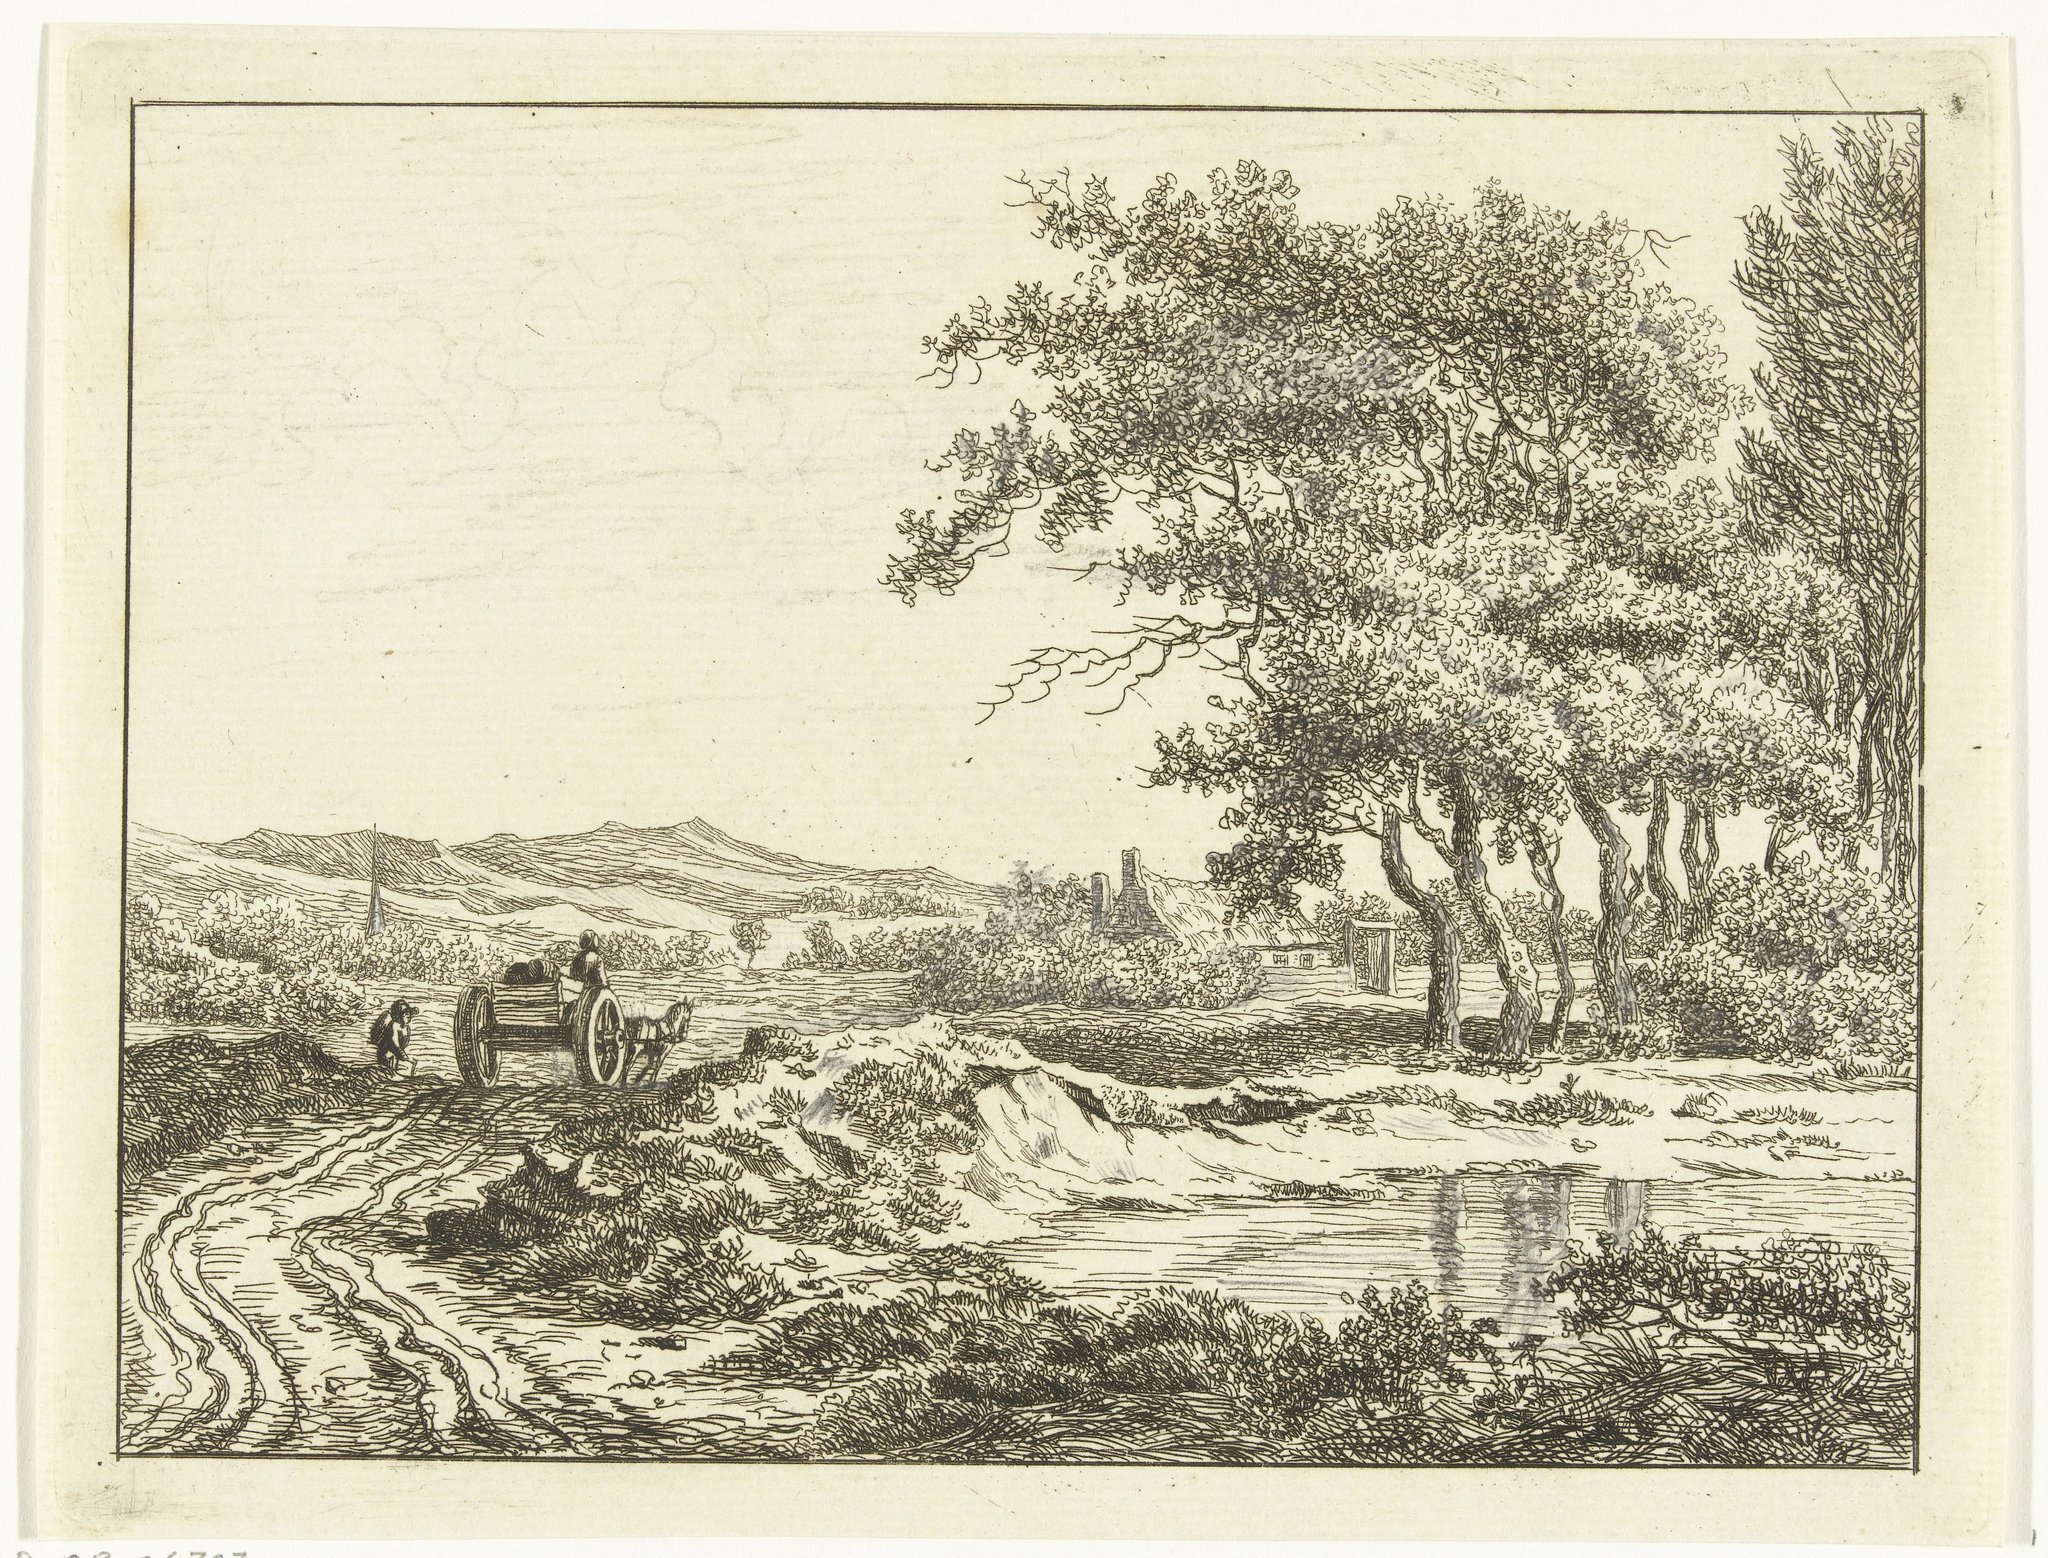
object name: print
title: Kar op een landweg bij de duinen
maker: anthonie van den bos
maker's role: draughtsman, print maker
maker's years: 1763-1838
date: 1778-1838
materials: paper, pencil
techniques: etching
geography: netherlands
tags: ruin of a dwelling, house, castle, etc.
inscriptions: collector's mark: Lugt 2228